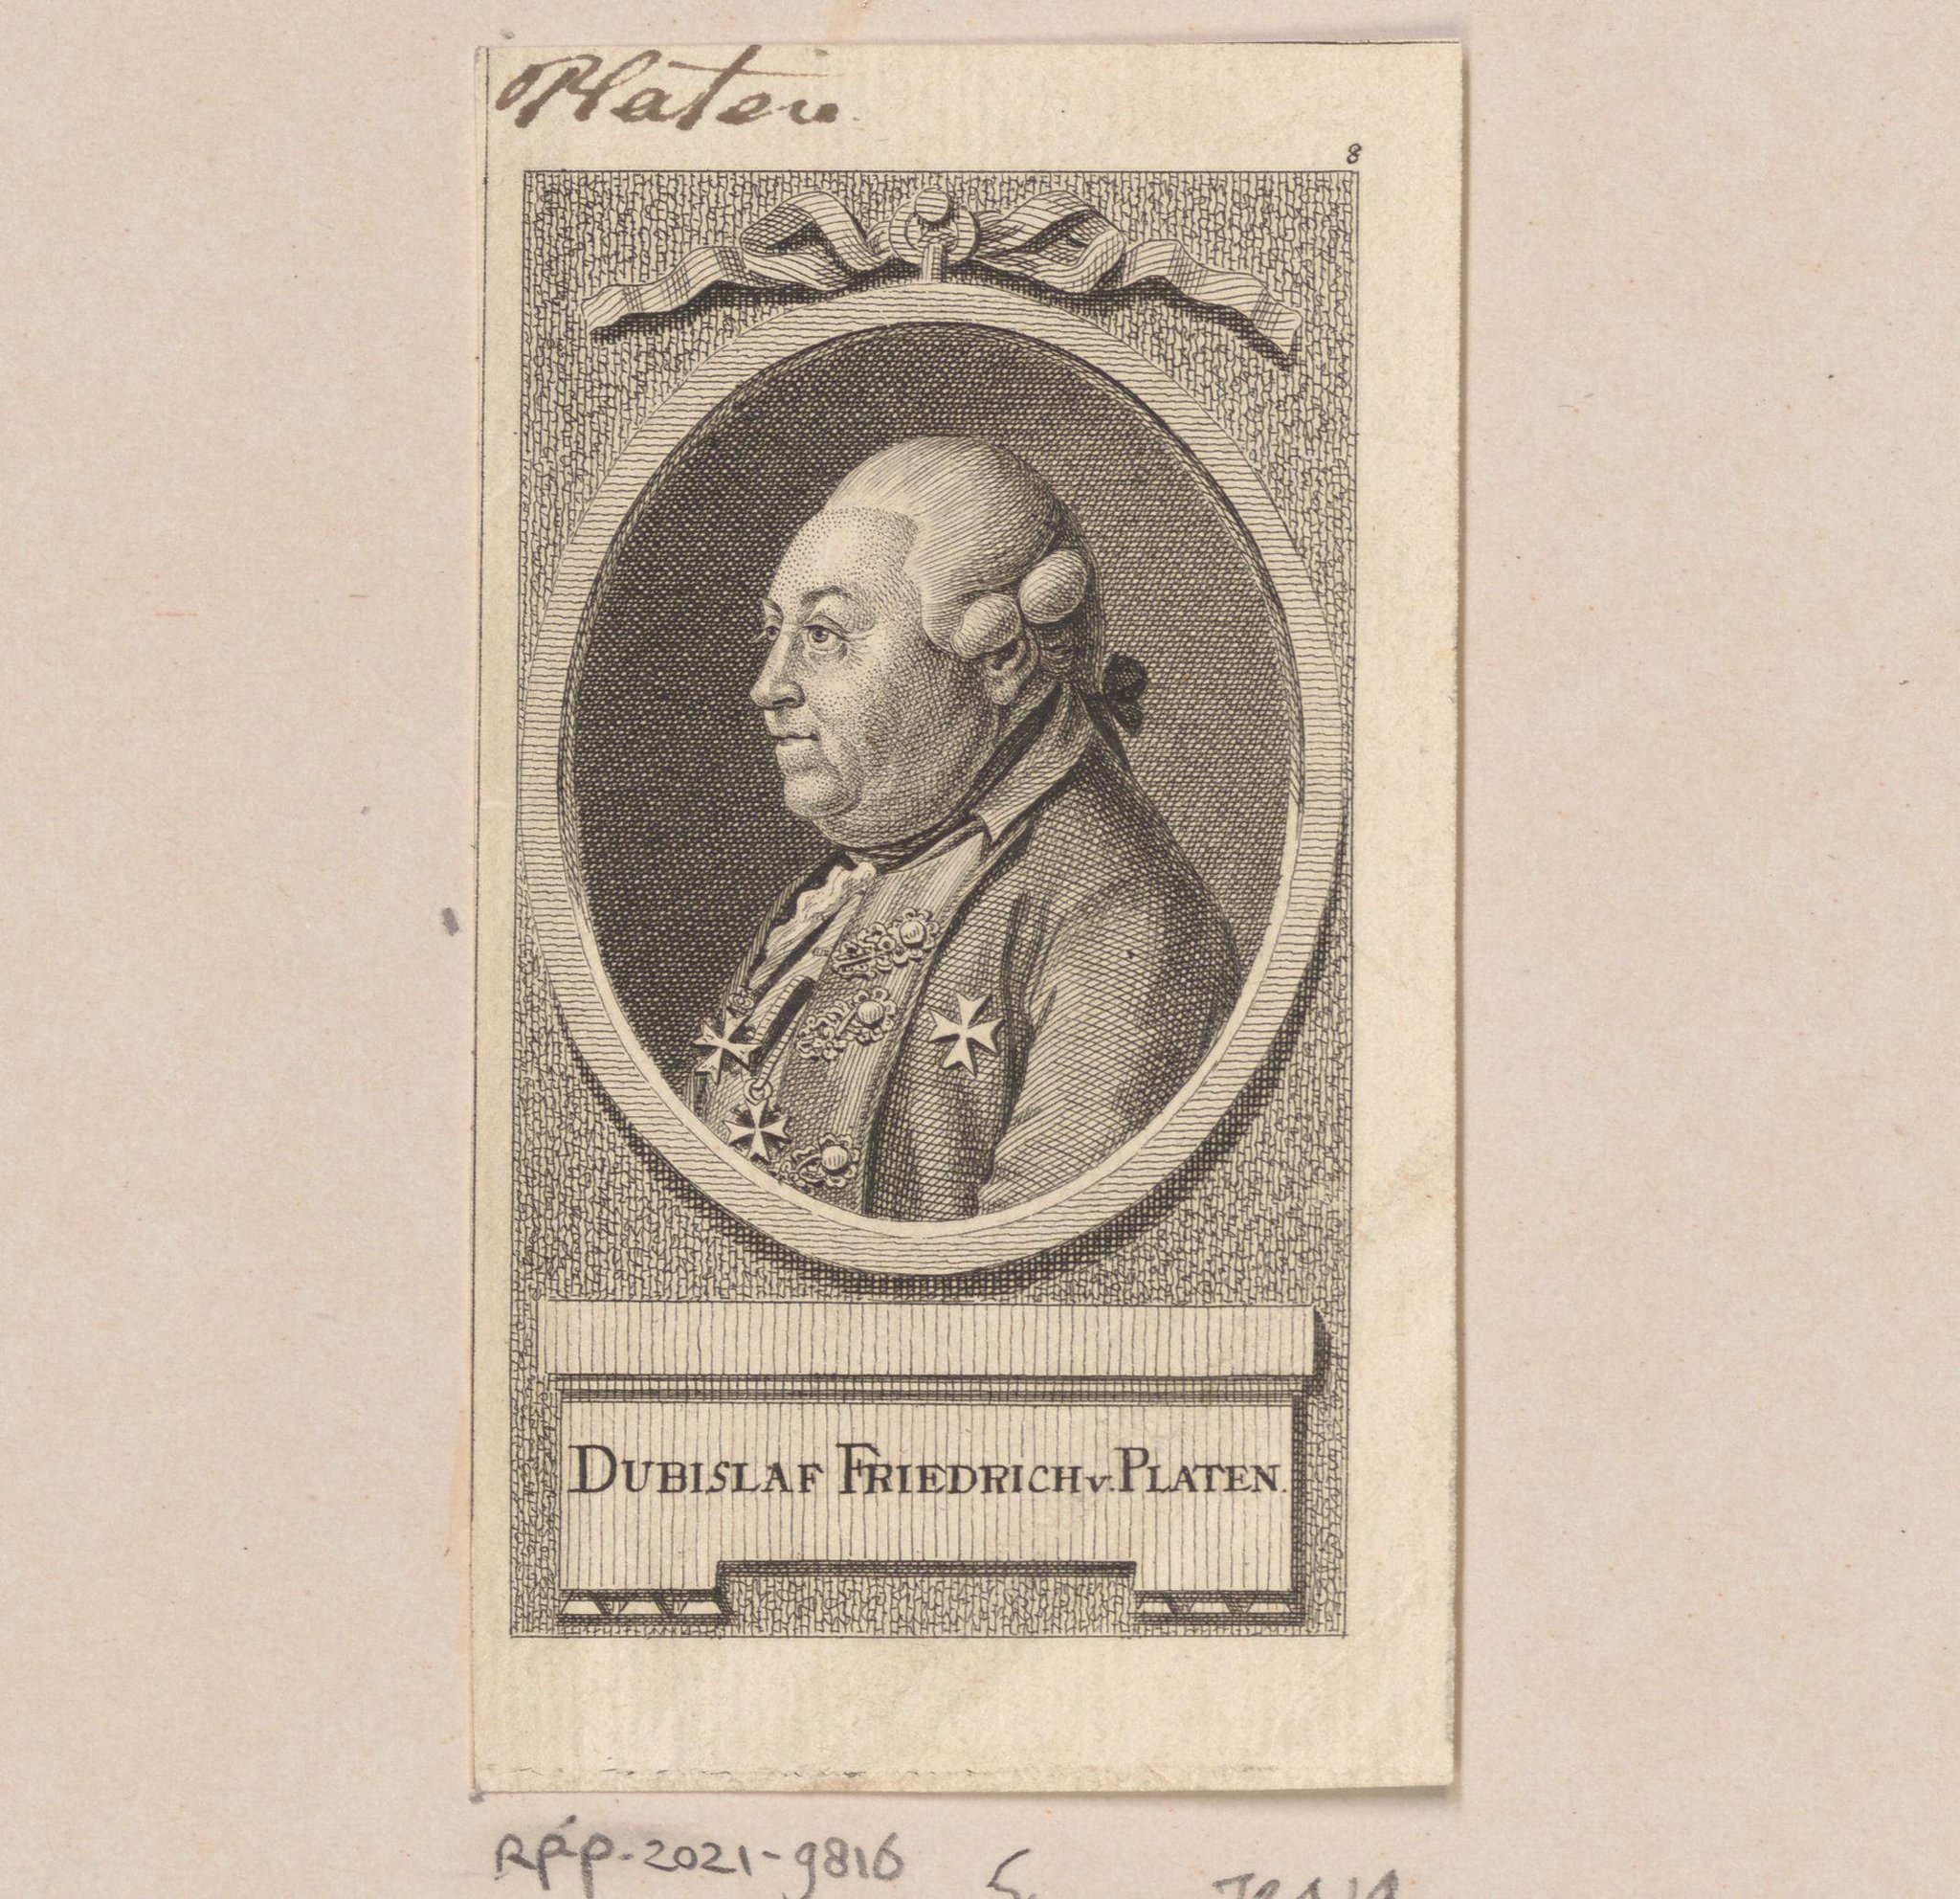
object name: print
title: Portret van Dubislav Friedrich von Platen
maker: Anonymous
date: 1750-1824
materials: paper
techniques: engraving, etching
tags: adult man, historical persons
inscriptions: inscription: ‘Platen’